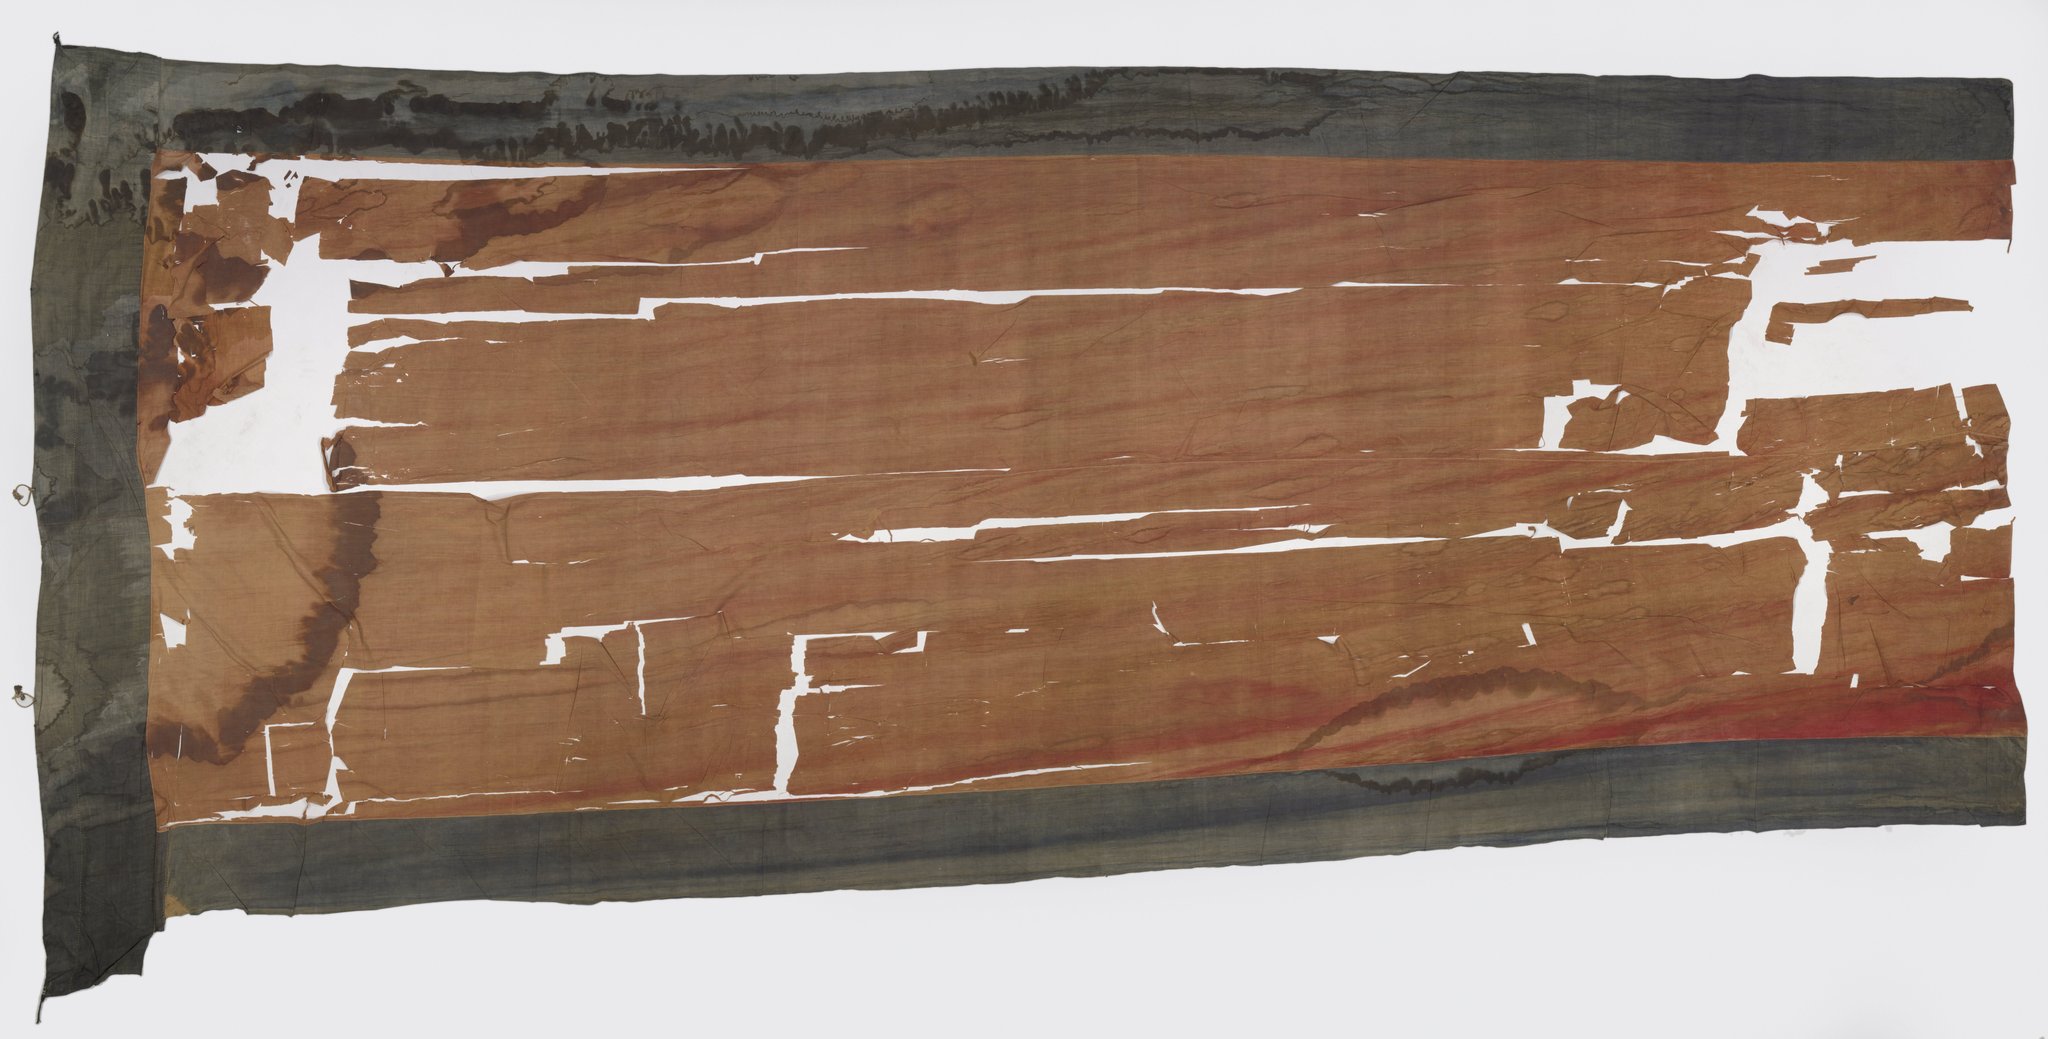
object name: flag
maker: Anonymous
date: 1750-1830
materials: cotton, linen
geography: indonesian archipelago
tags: flag, colours (as symbol of the state, etc.), dutch east indies, the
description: Rode vlag met een blauwe horizontale baan langs boven- en onderzijde, en een blauwe broek.